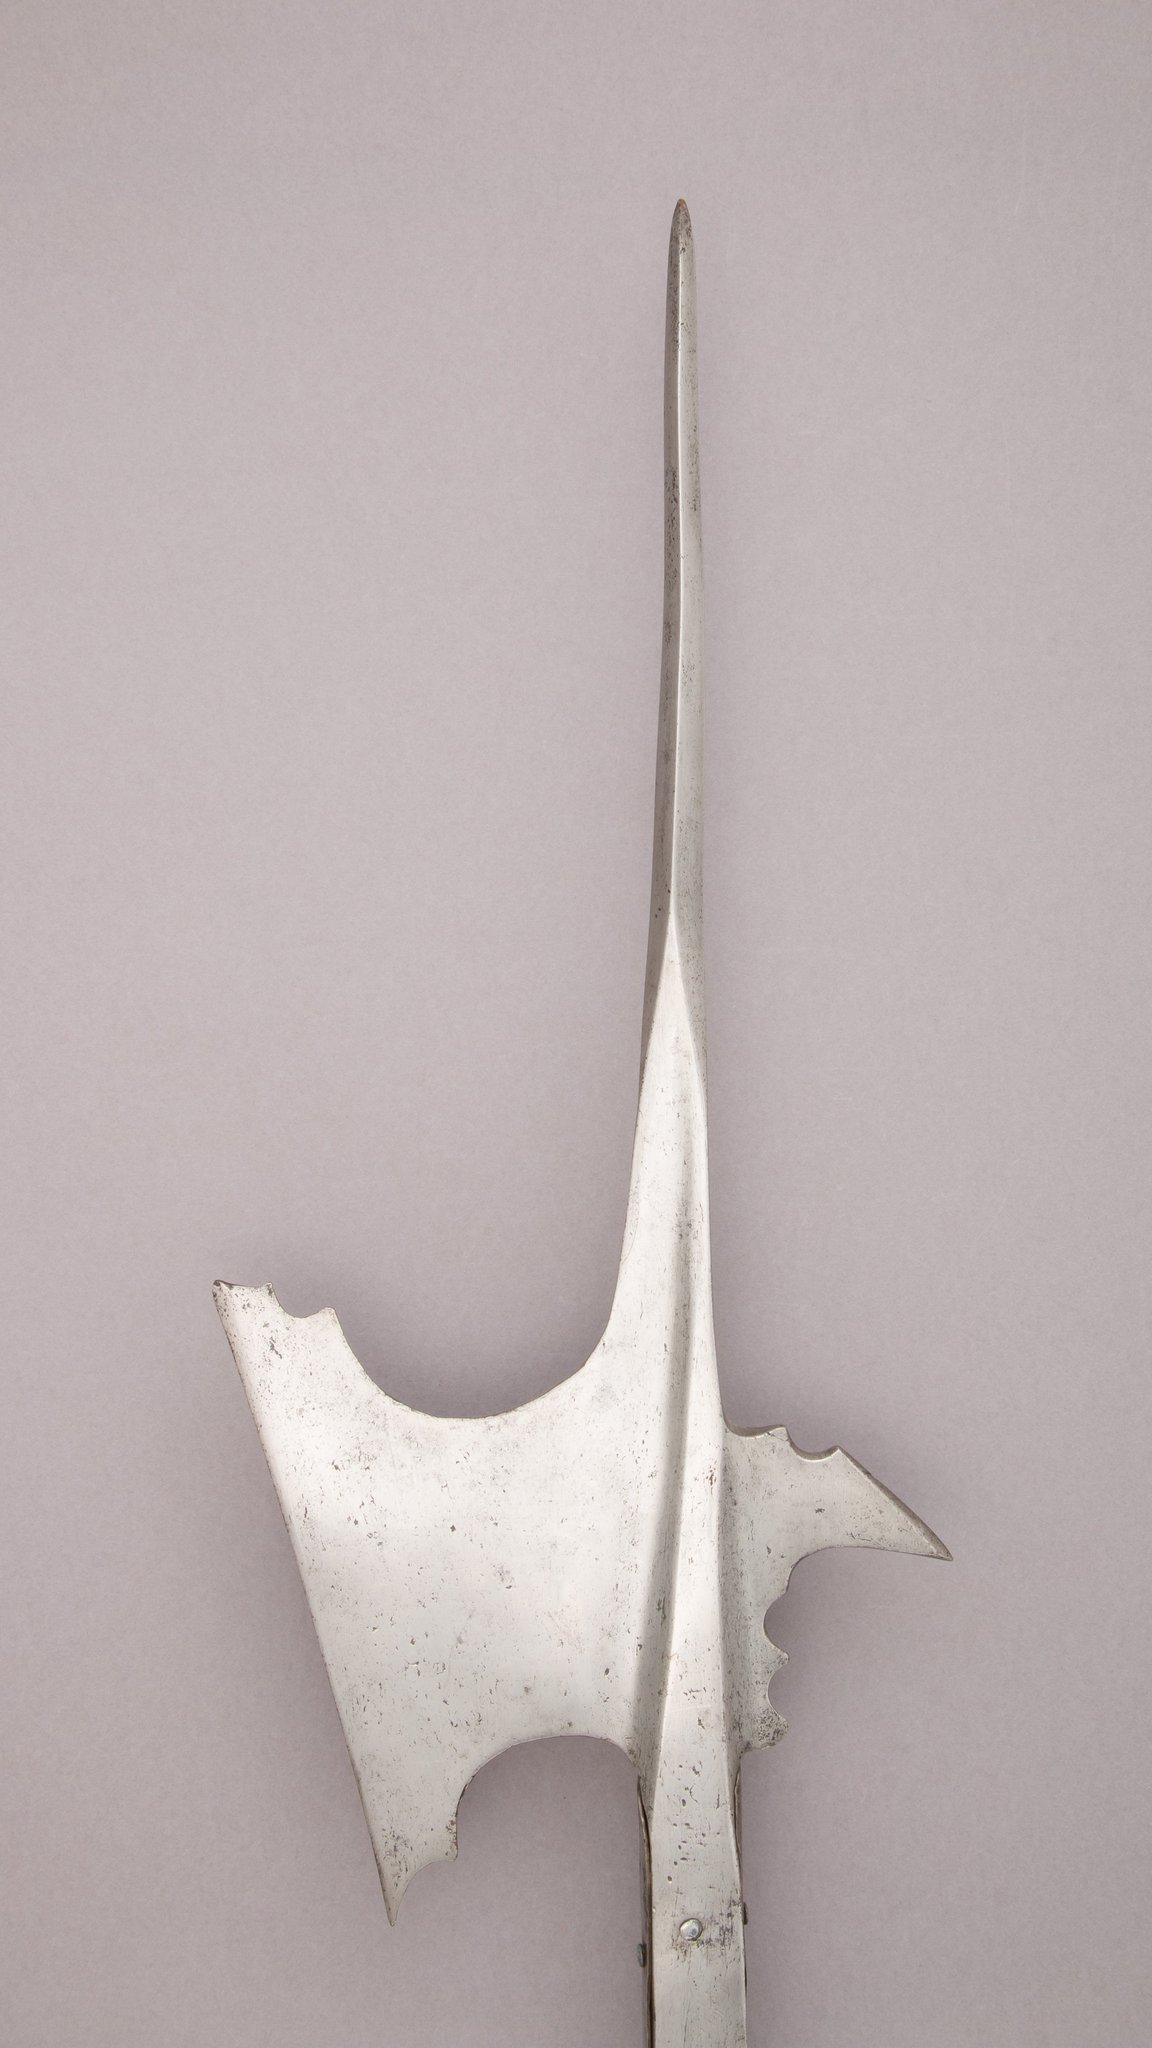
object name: halberd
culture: german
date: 1501-1533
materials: steel, textile, wood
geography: germany